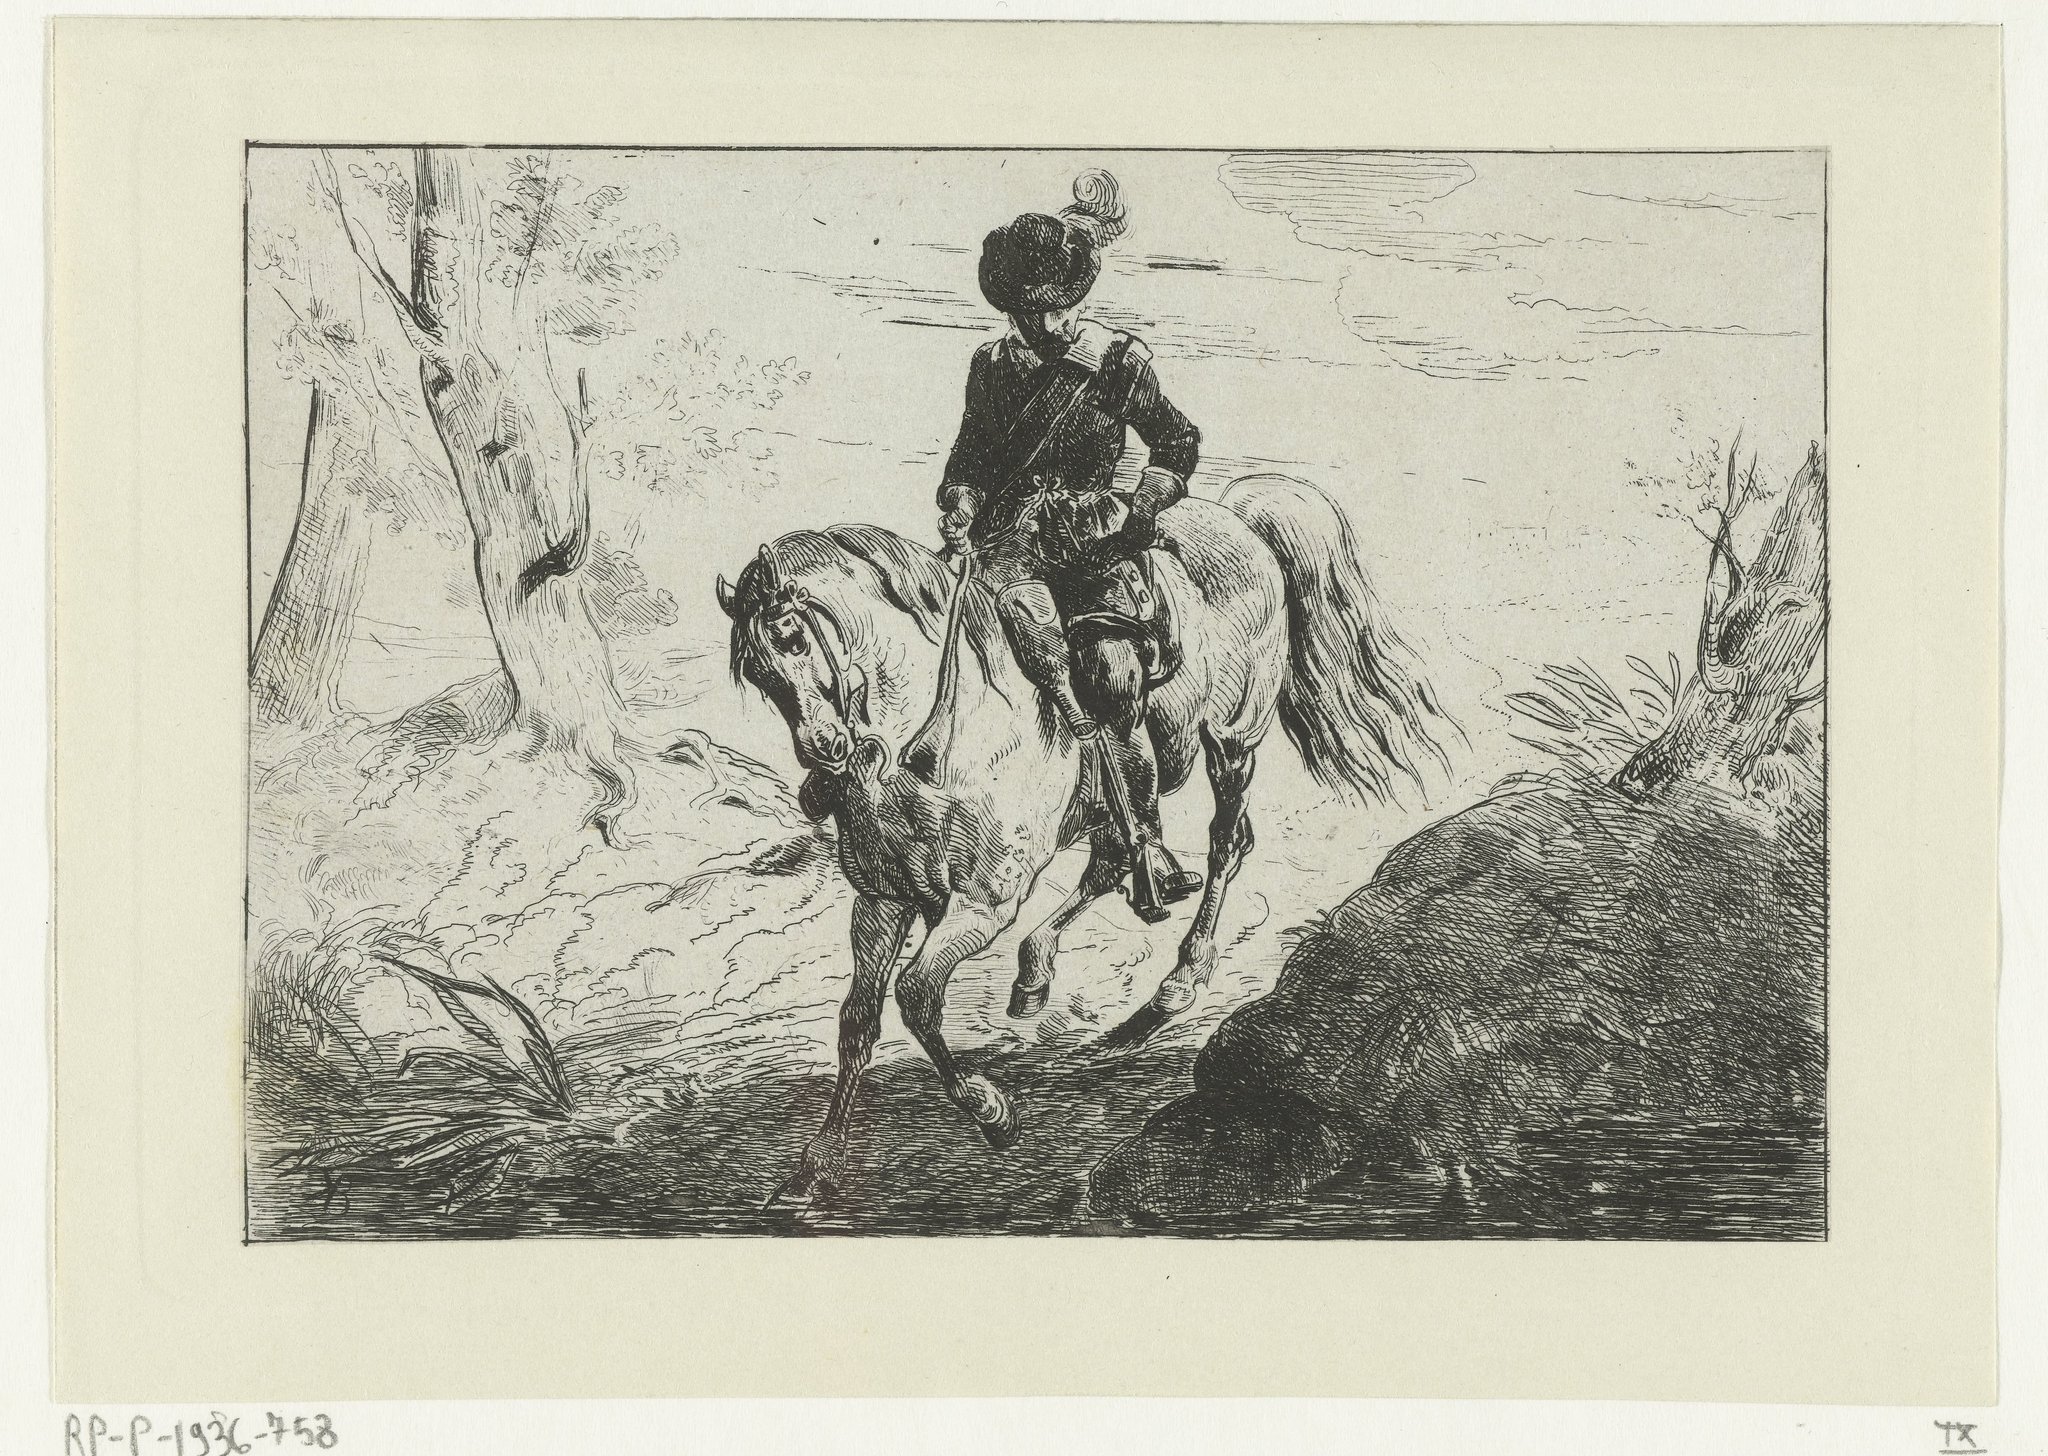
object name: print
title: Ruiter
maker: karel frederik bombled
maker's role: draughtsman, print maker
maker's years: 1822-1902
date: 1832-1902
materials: paper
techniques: drypoint, etching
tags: riding a horse, ass, or mule; rider, horseman, forest path or lane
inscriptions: collector's mark: Lugt 2228, collector's mark: Lugt 2760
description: niet genoemd in literatuur. 9 staten aanwezig in het RMA